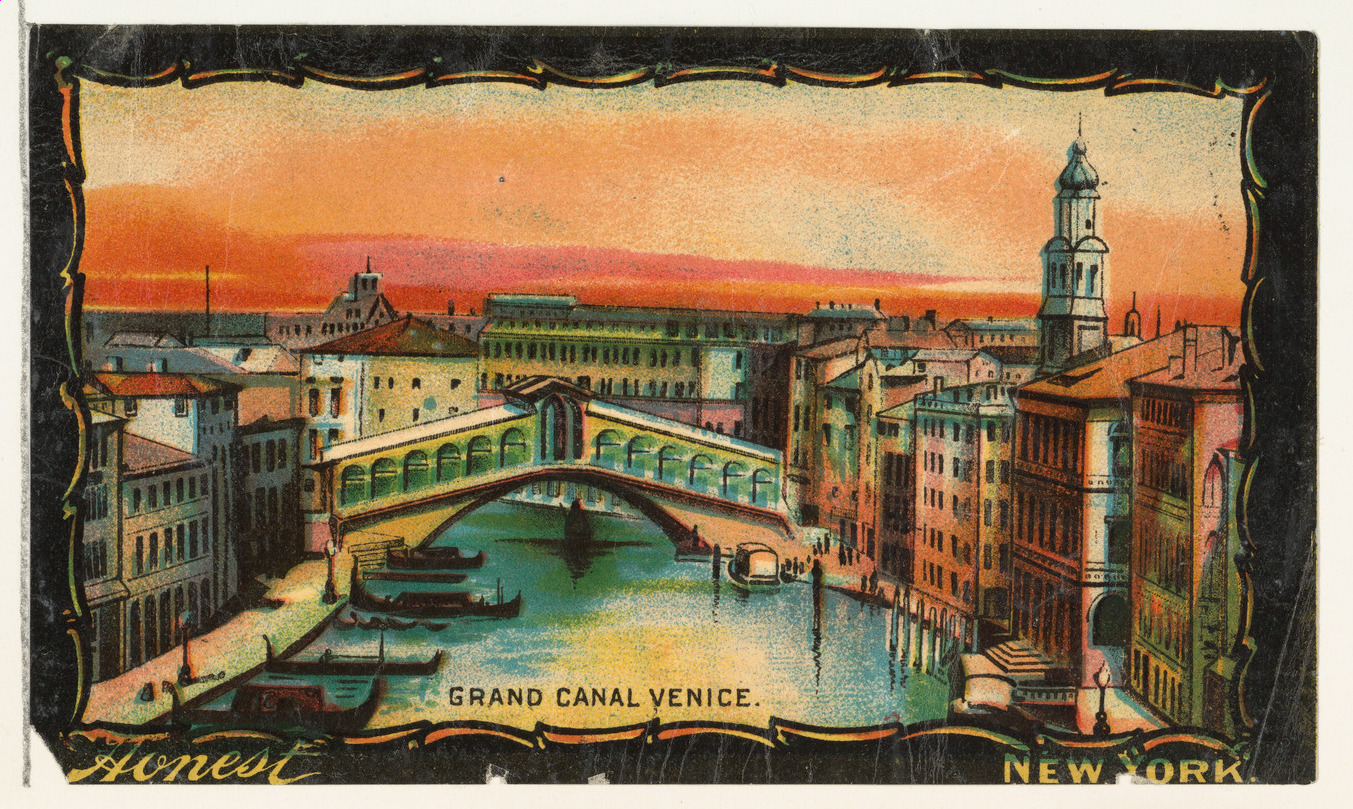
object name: print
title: Grand Canal, Venice, from the Transparencies series (N137) issued by W. Duke, Sons & Co. to promote Honest Long Cut Tobacco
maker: w. duke, sons & co.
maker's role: publisher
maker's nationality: american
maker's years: 1870-1920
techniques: color lithograph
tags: buildings,bridges,canals,venice